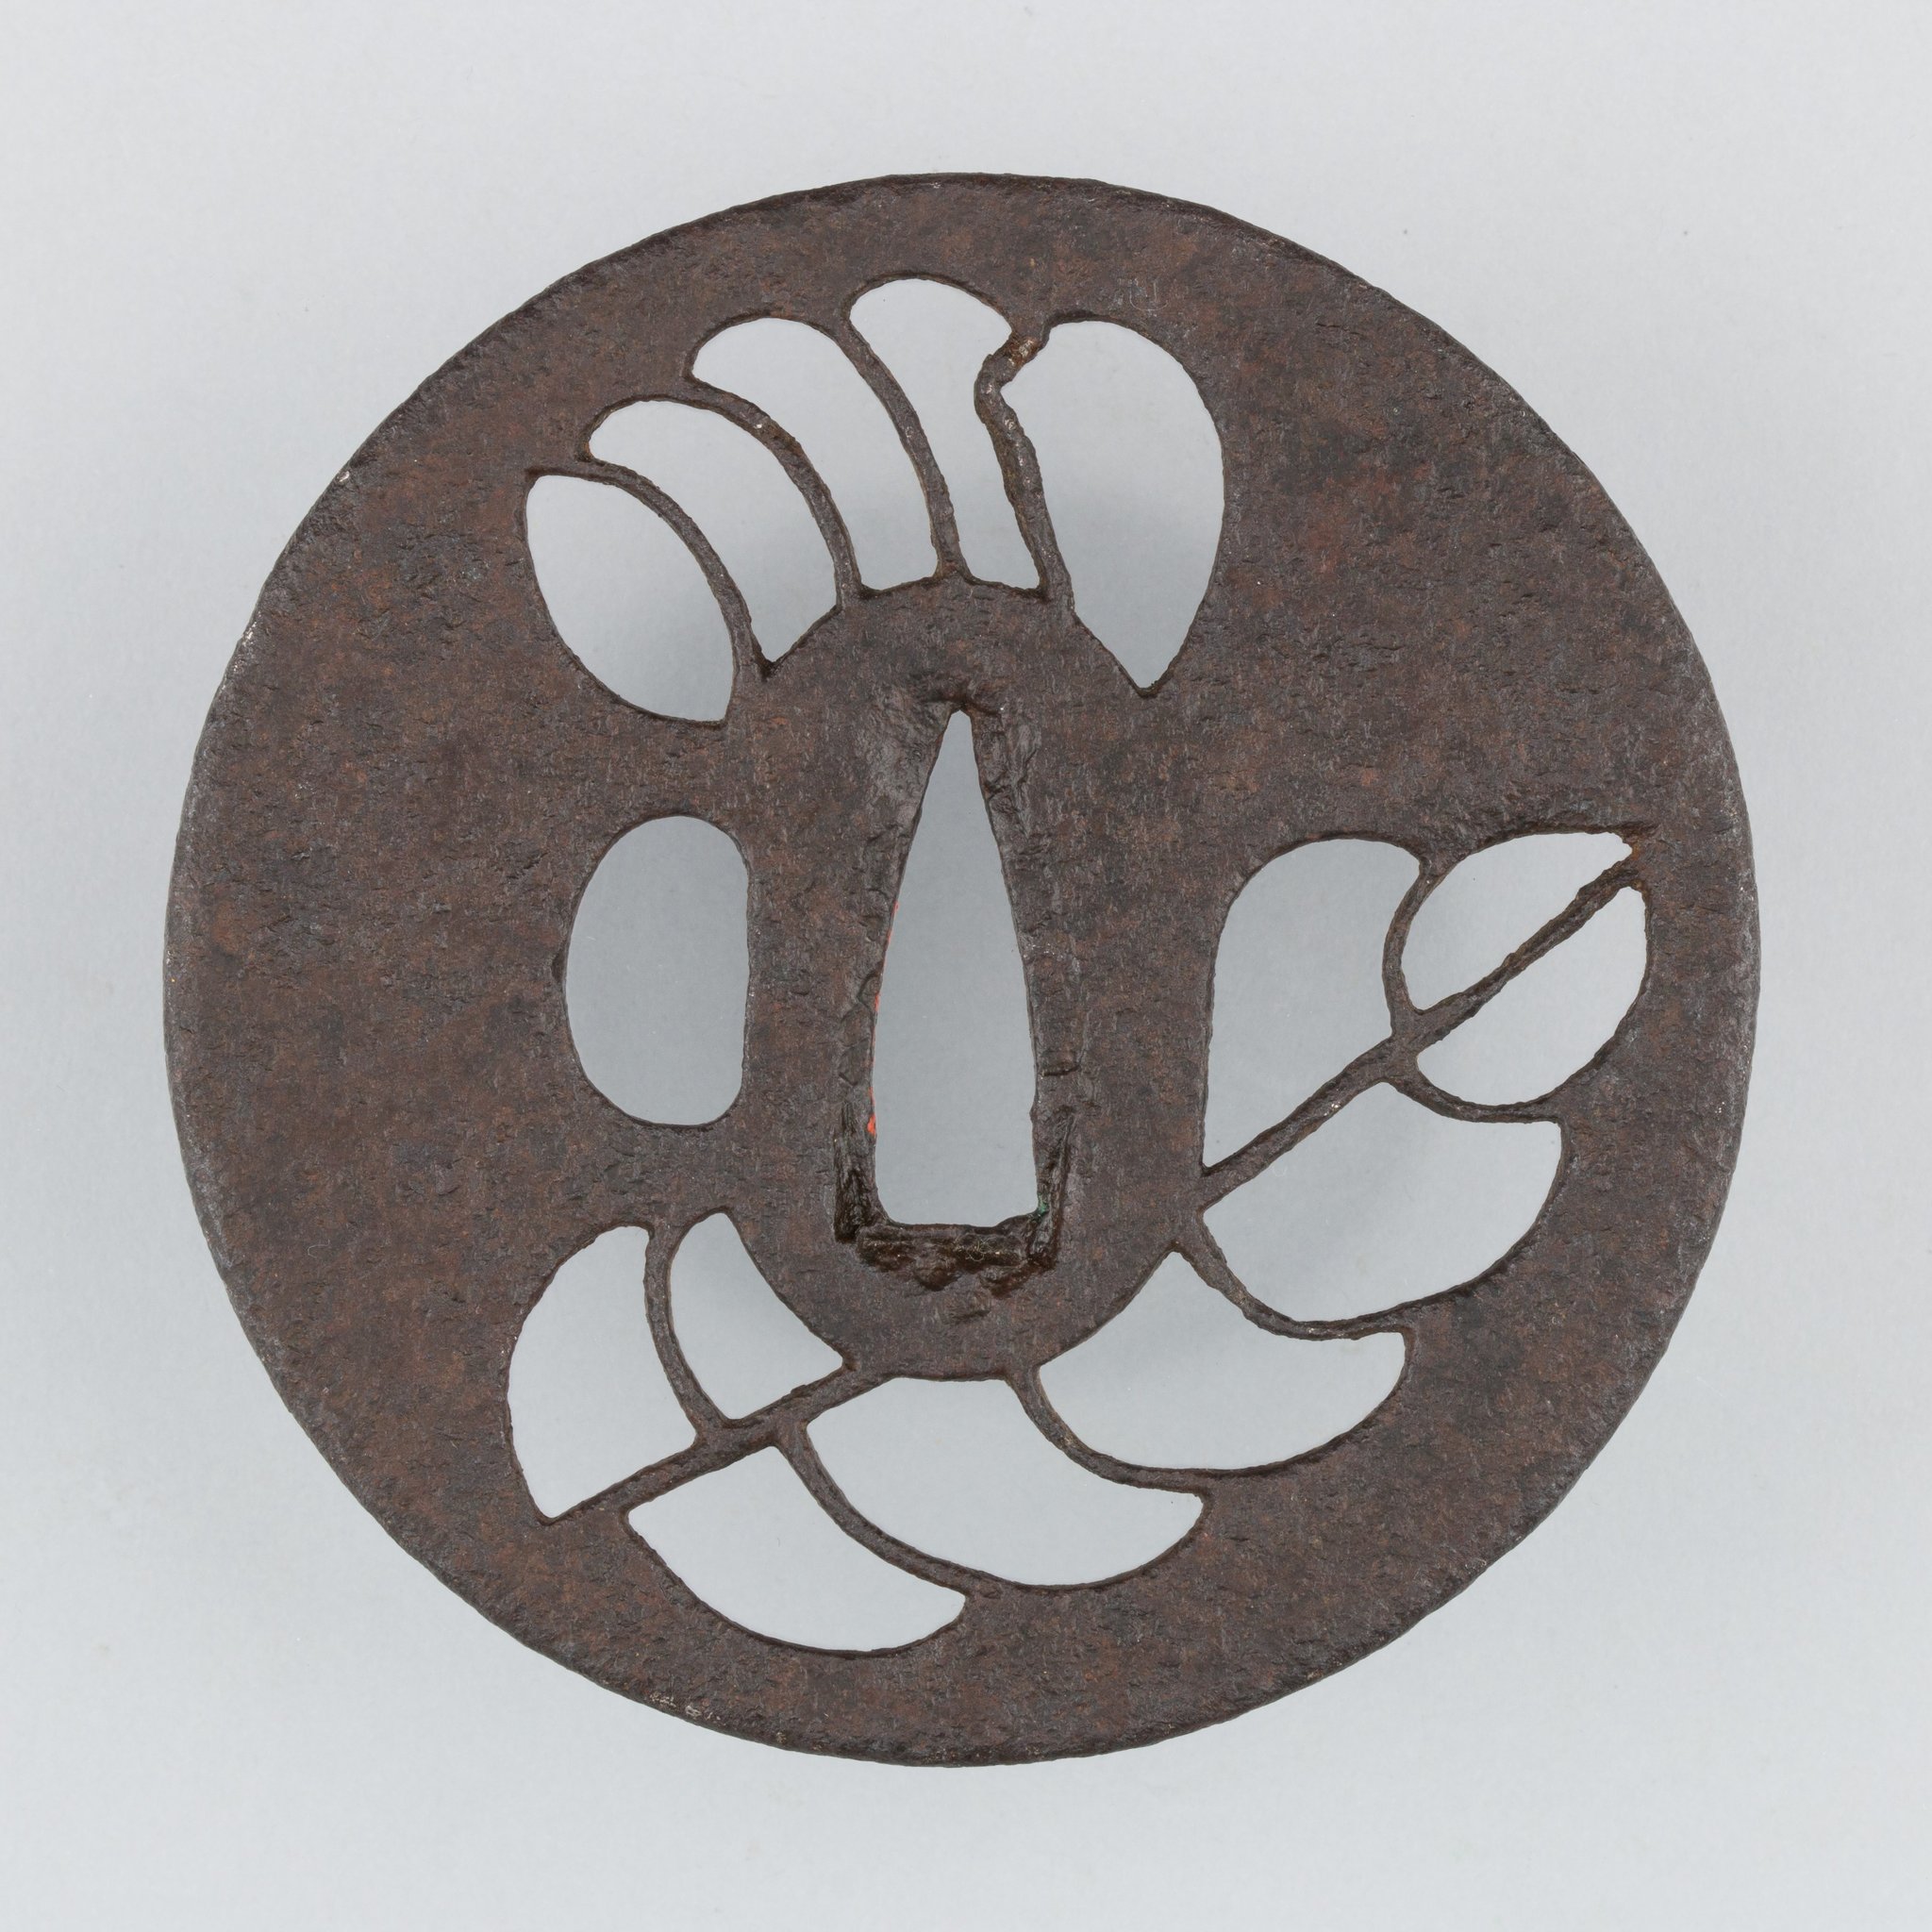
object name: sword guard tsuba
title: Sword Guard (Tsuba)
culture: japanese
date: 1567-1600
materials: copper, iron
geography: japan